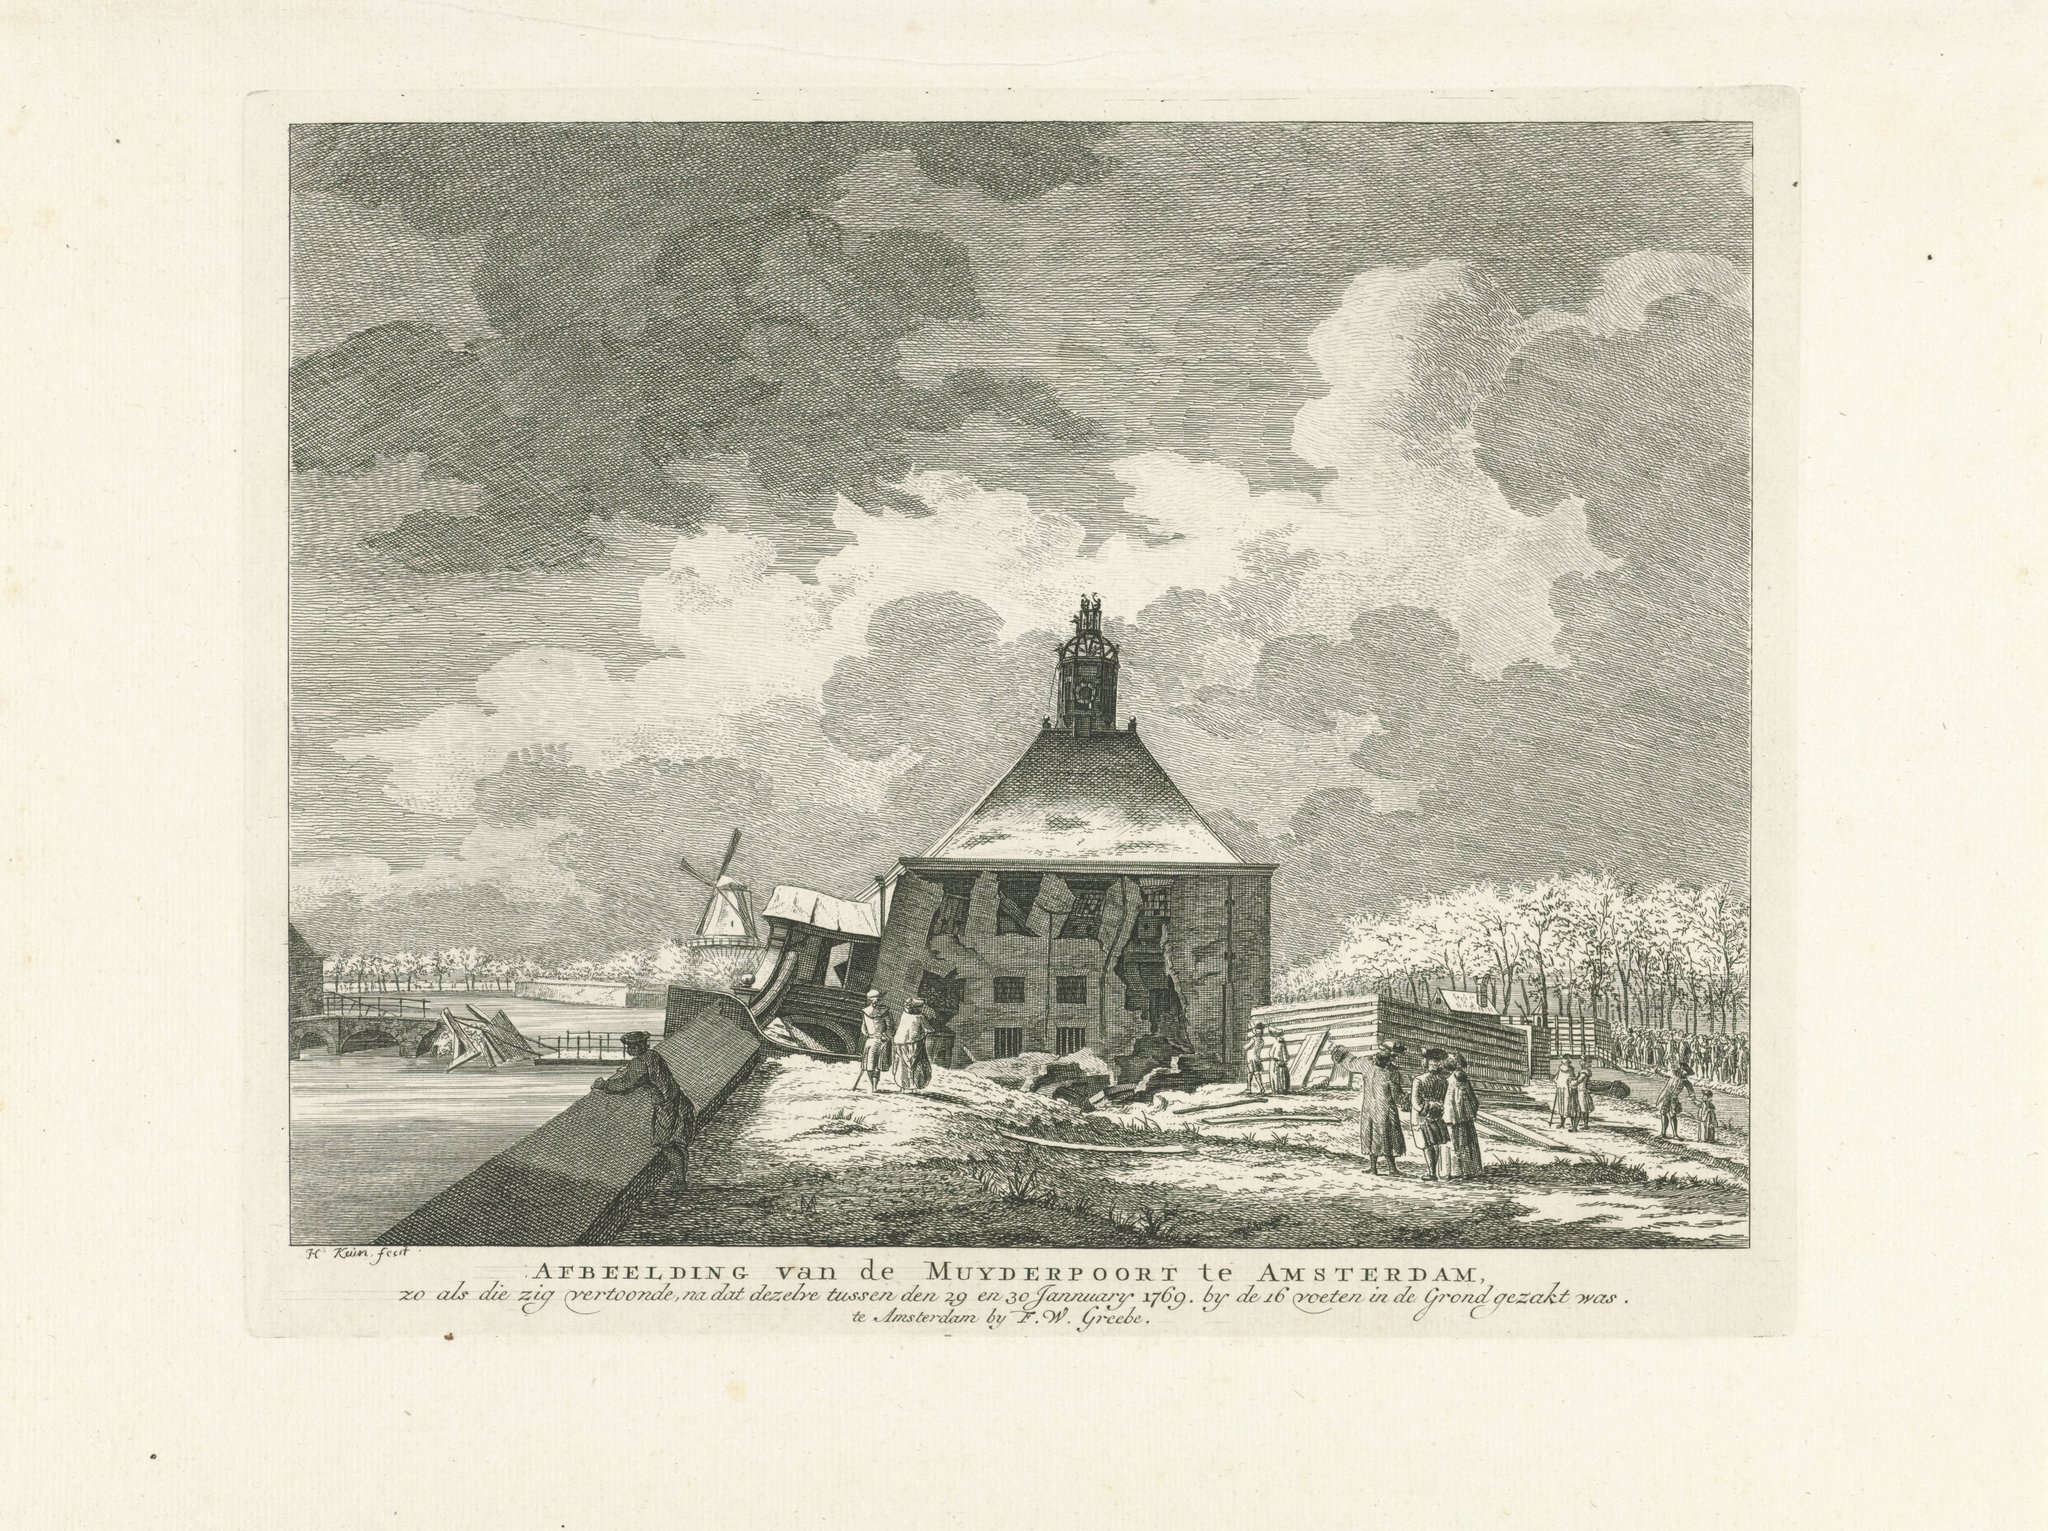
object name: print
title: Afbeelding van de Muyderpoort te Amsterdam, zo als die zig vertoonde, na dat dezelve tussen den 29 en 30 january 1769. by de 16 voeten in de grond gezakt was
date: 1769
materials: paper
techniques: engraving, etching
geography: northern netherlands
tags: city-gate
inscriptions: collector's mark: Lugt 2228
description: De verzakte Muiderpoort te Amsterdam, gezien vanaf de schans, 30 januari 1769. Met links de Singelgracht, rechts de Muidergracht. Op de voorgrond enkele toeschouwers.